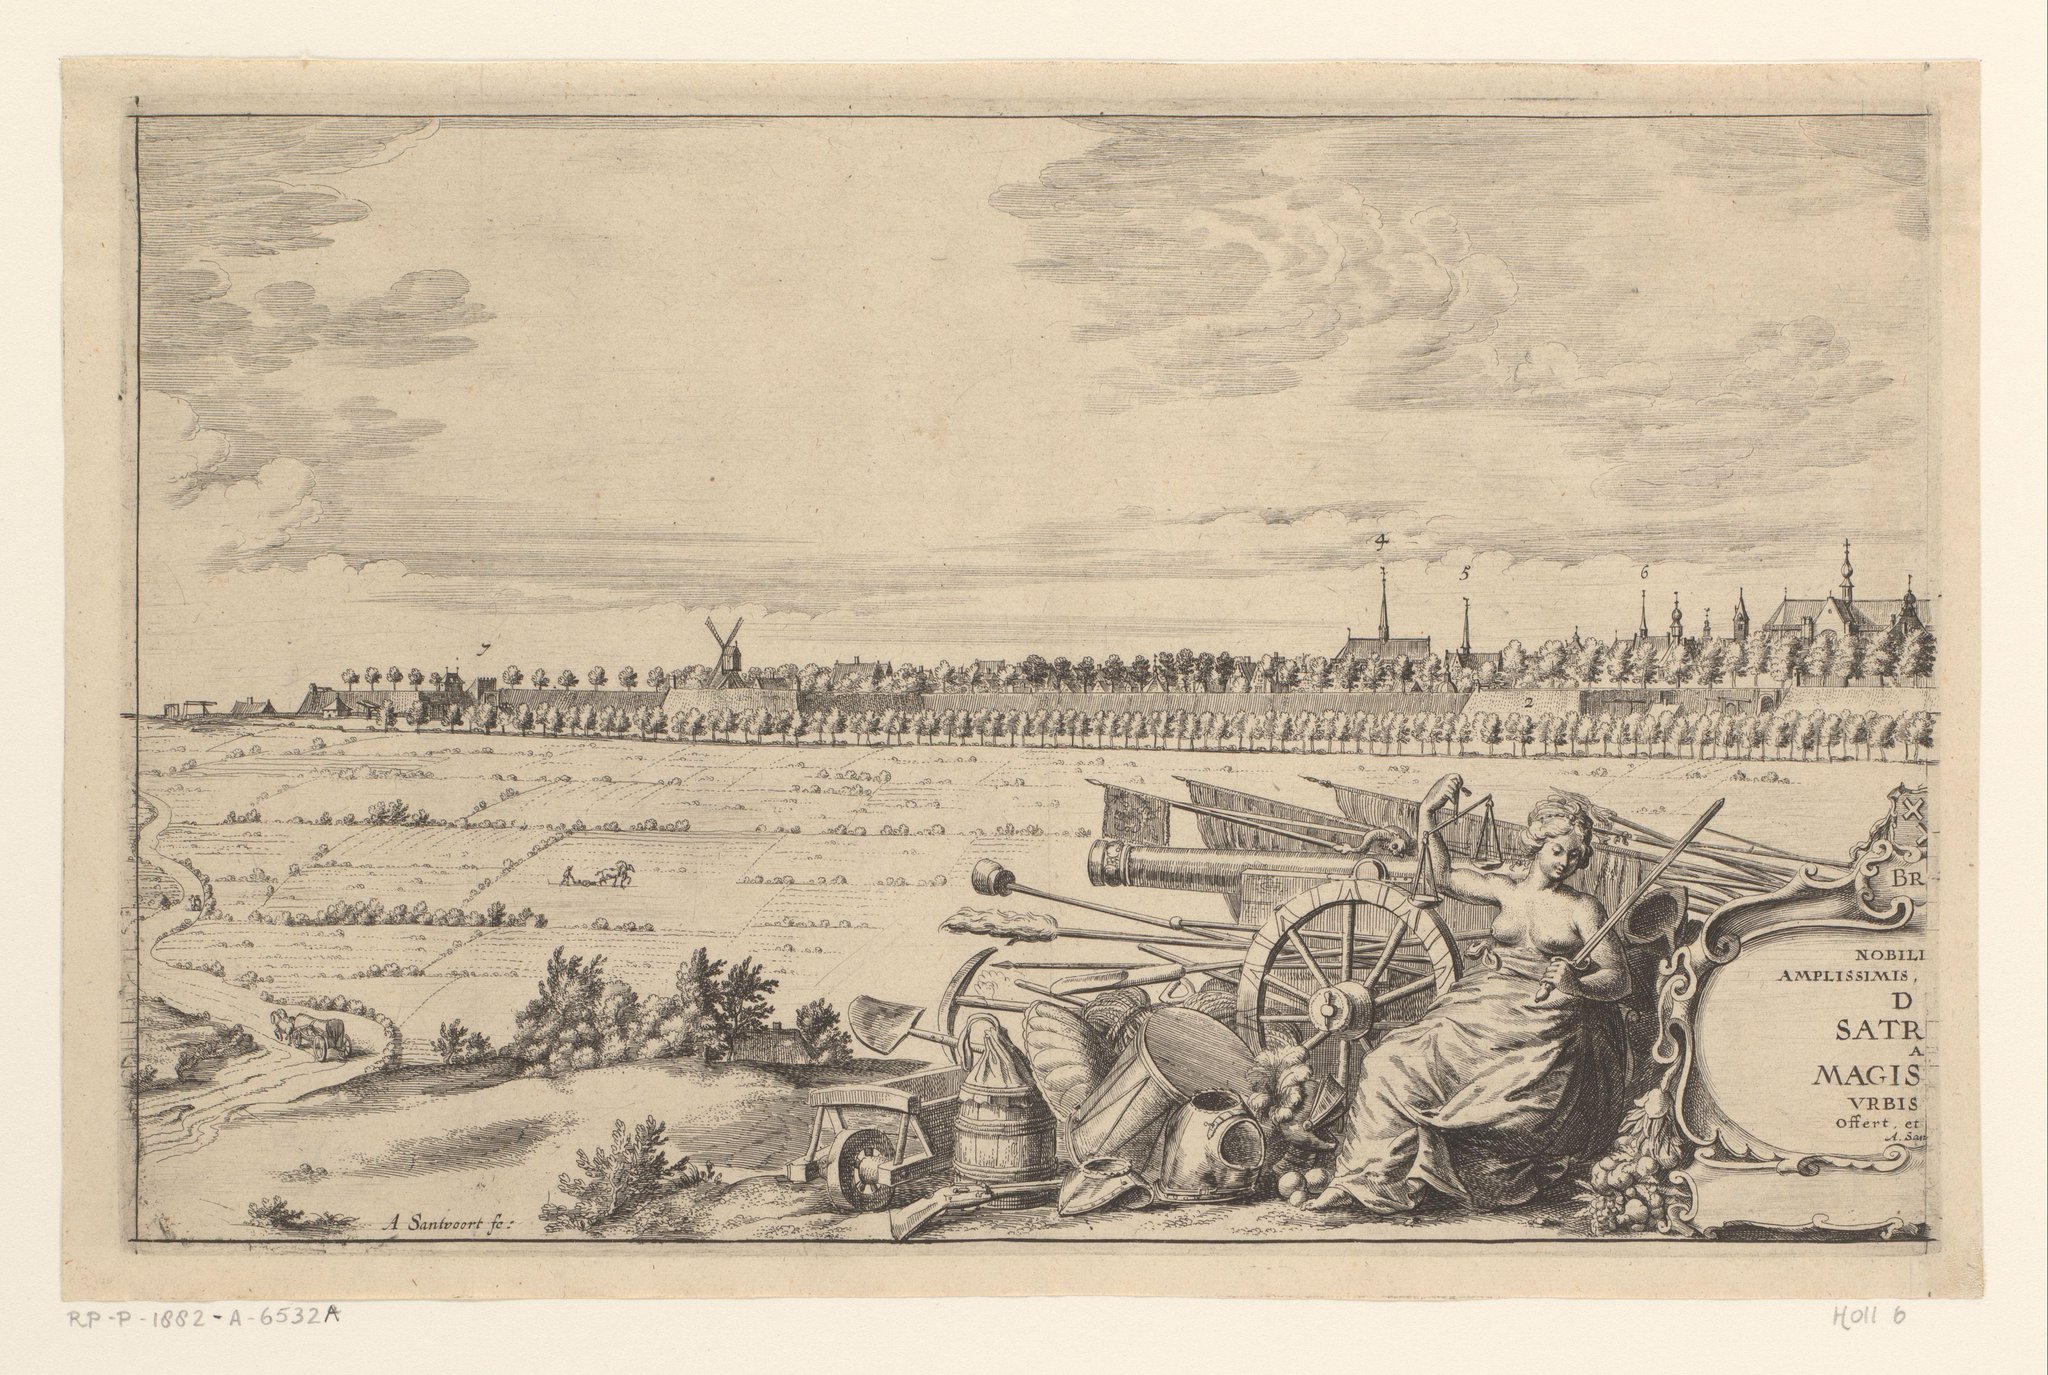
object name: print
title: Gezicht op Breda vanuit het noordwesten (linker blad)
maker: abraham dircksz. santvoort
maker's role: print maker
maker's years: 1614-1669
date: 1645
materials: paper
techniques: etching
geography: netherlands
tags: city-view, and landscape with man-made constructions, justice, 'justitia'; 'giustitia divina' (ripa) ~ one of the four cardinal virtues, weapons, agricultural implements, military clothing and other equipment (uniforms, cap, armour, helmet, etc.)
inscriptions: collector's mark: Lugt 2228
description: Justitia zit naast een cartouche. Naast en achter haar liggen wapens, delen van wapenrusting en agrarische werktuigen. In de verte een gezicht op de stad Breda met rechts het schip van de Grote Kerk.